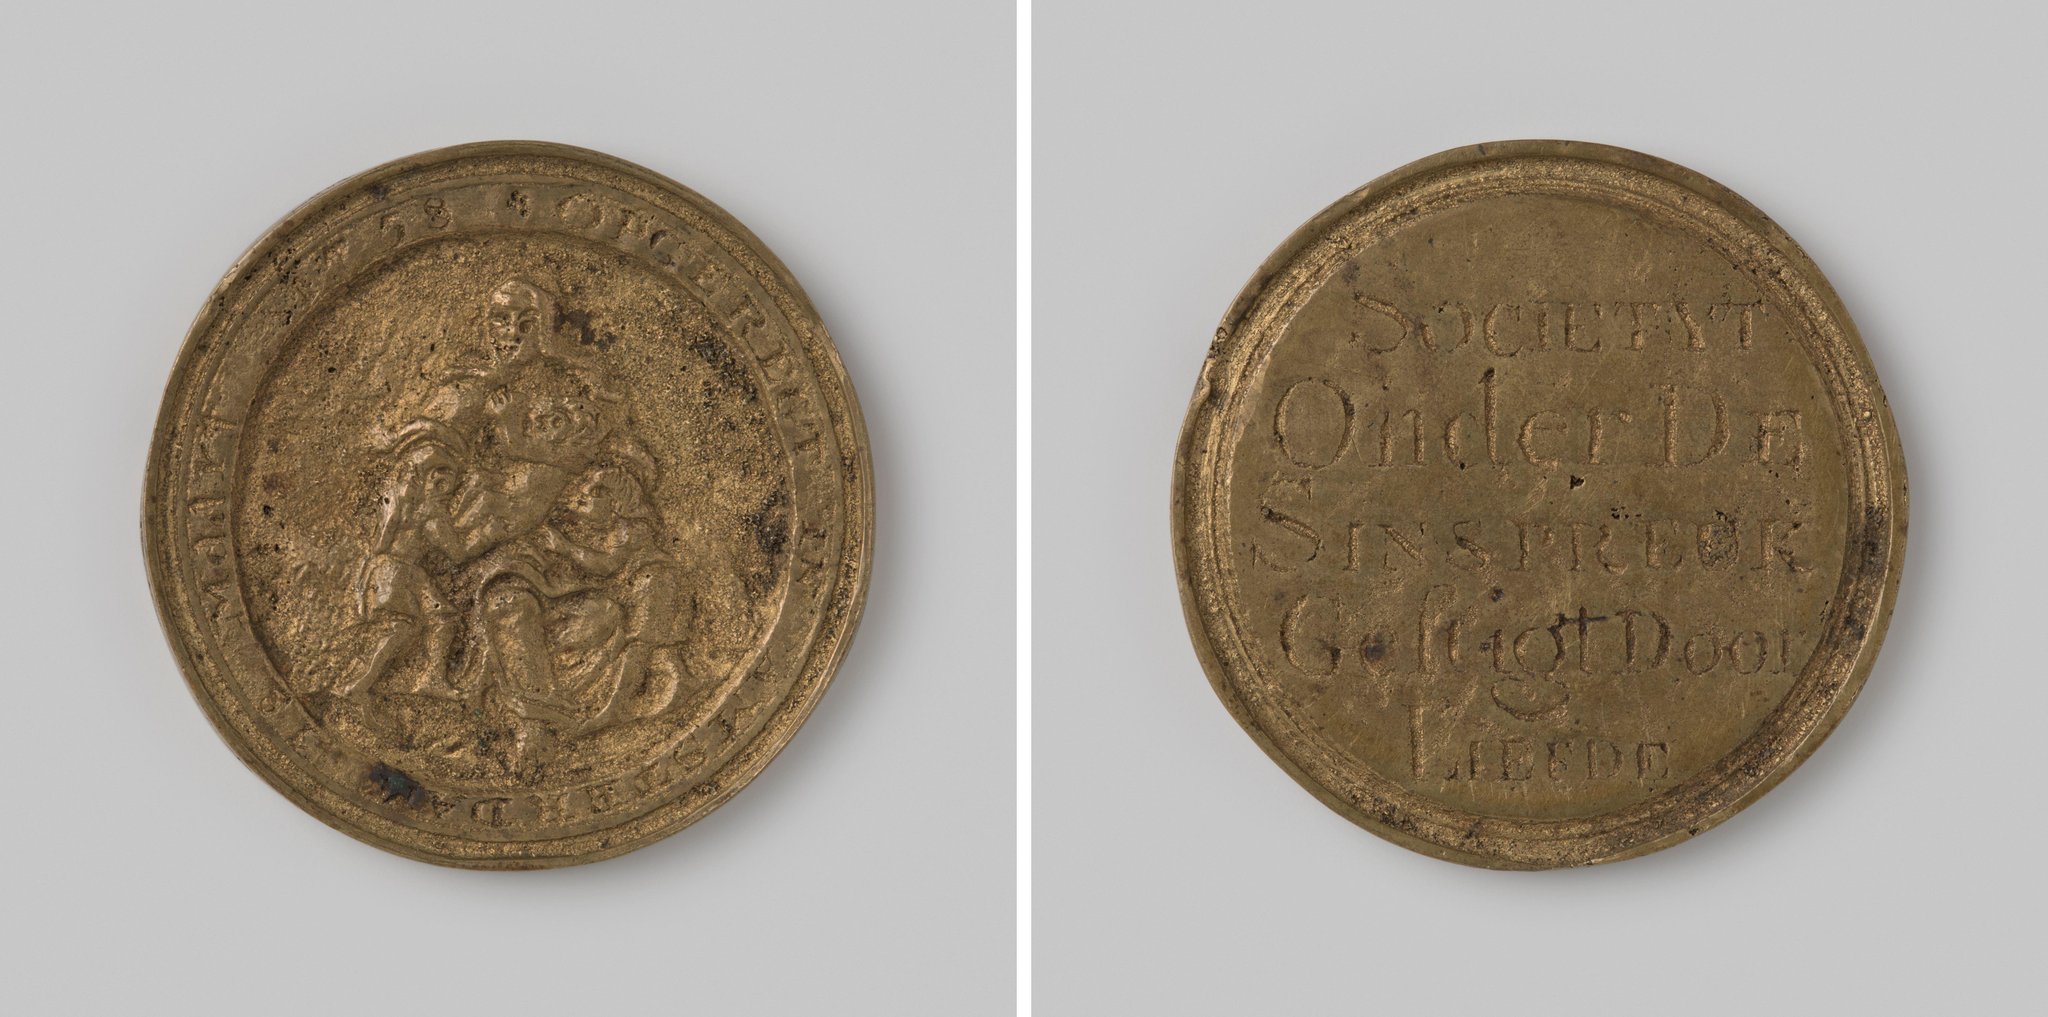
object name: history medal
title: Oprichting van de Societeit onder de zinspreuk "Gesticht door liefde" te Amsterdam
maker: Anonymous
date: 1758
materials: copper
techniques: engraving, striking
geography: amsterdam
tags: amsterdam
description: Koperen penning. Voorzijde: vrouw met weduwekap aan wie zich drie kinderen vastklampen binnen omschrift. Keerzijde: opschrift